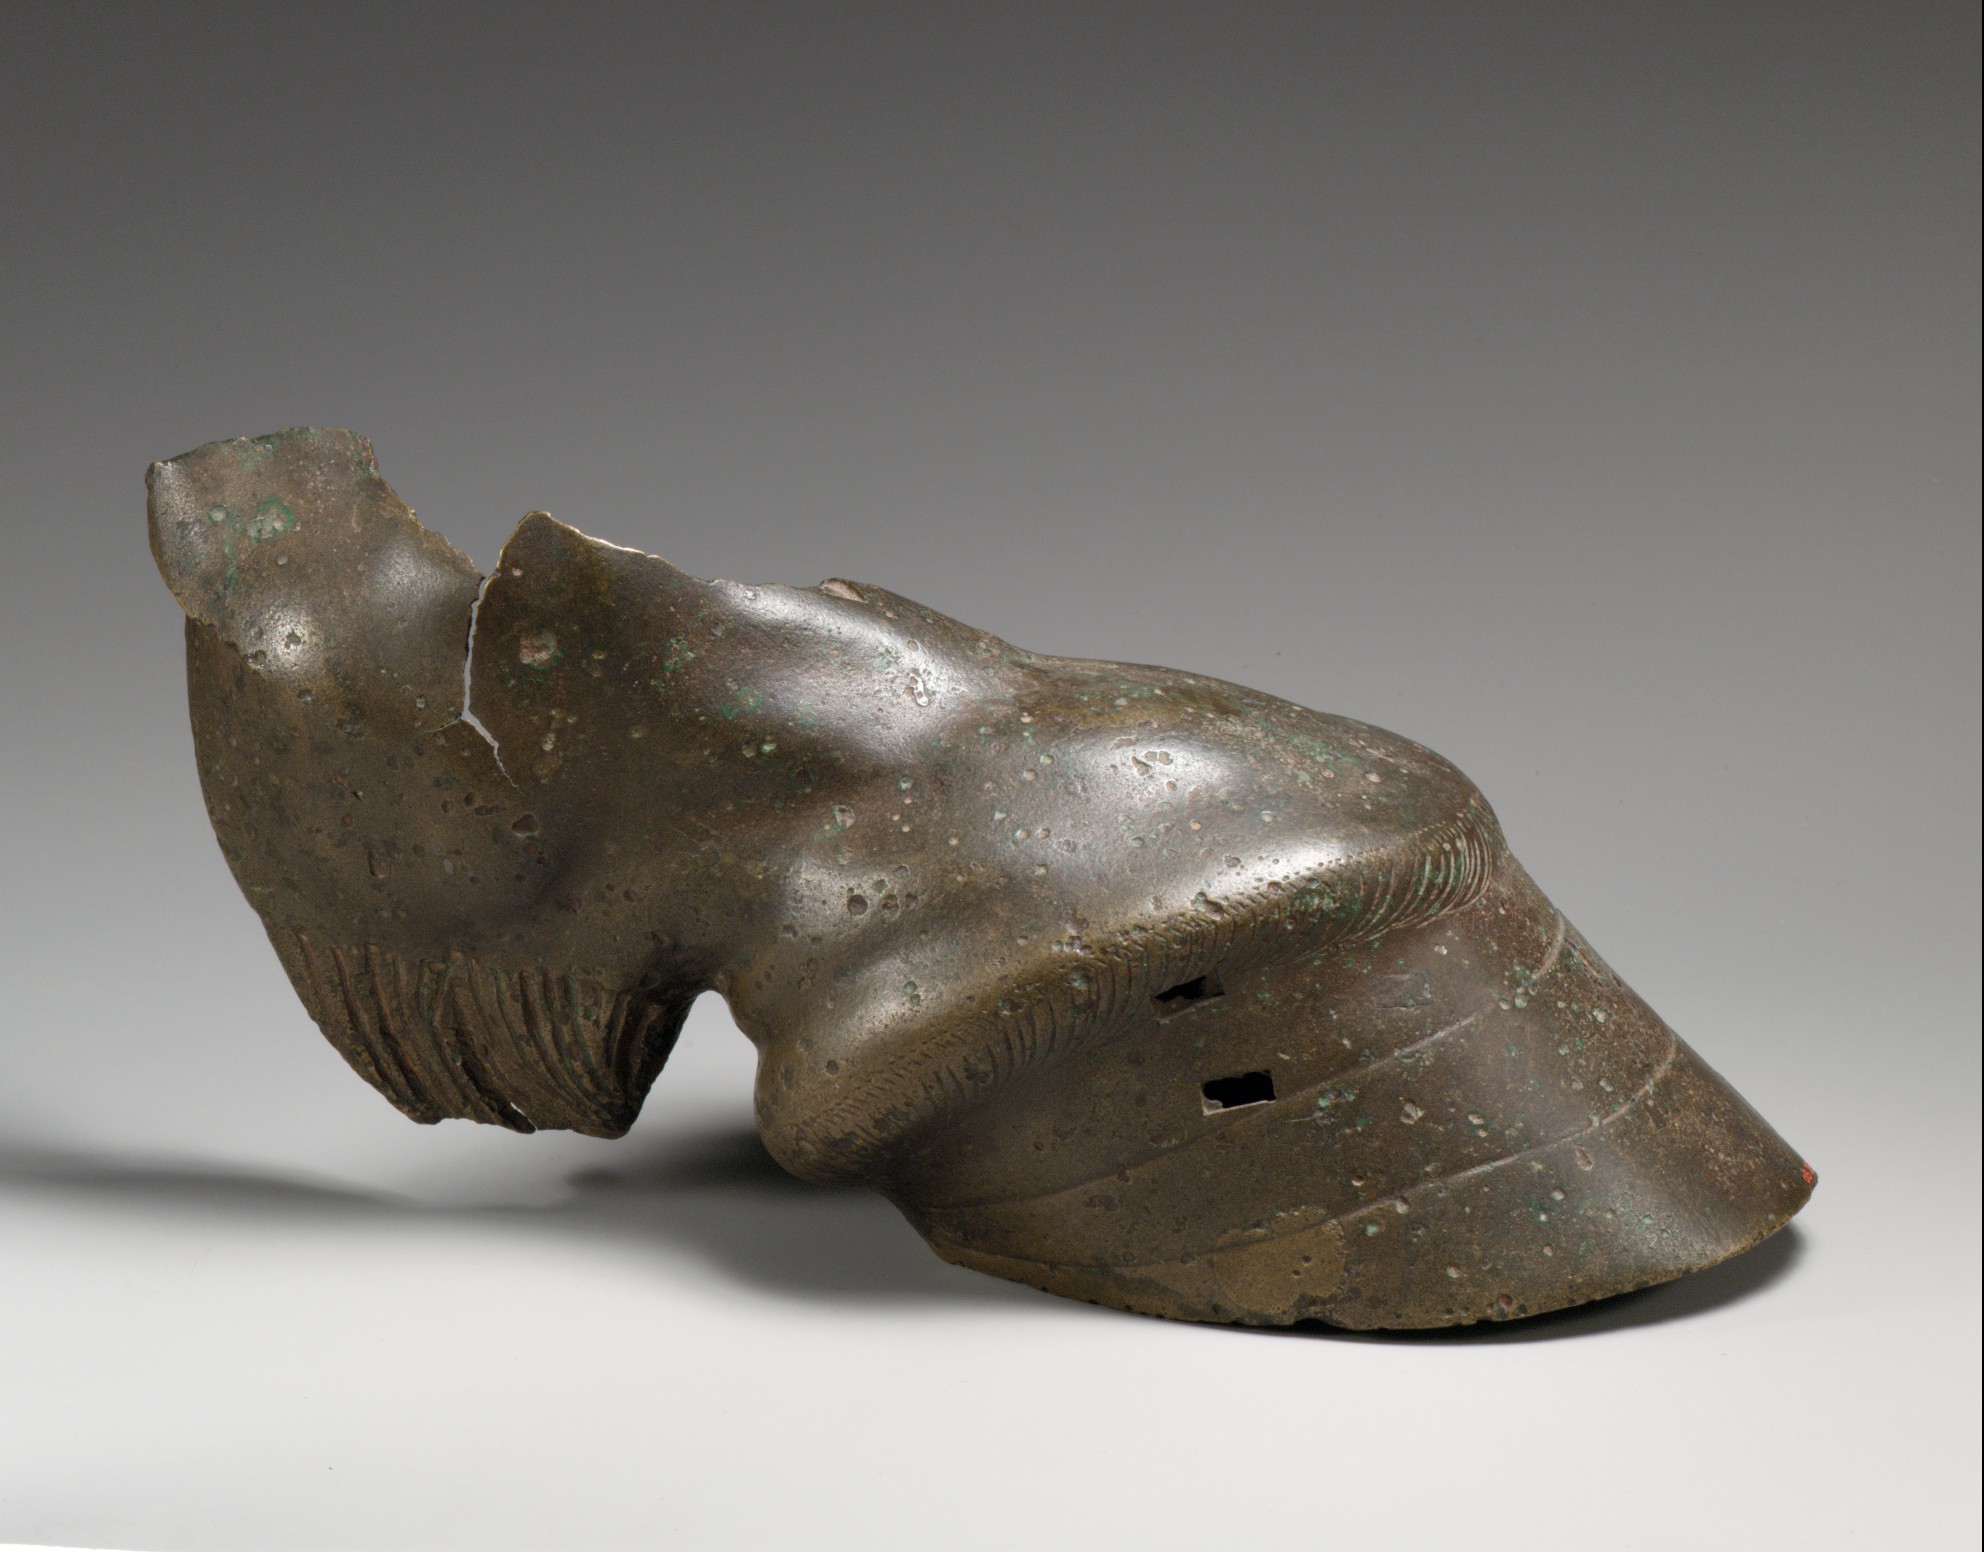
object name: horse hoof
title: Bronze hoof of a horse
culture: roman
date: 1-200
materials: bronze